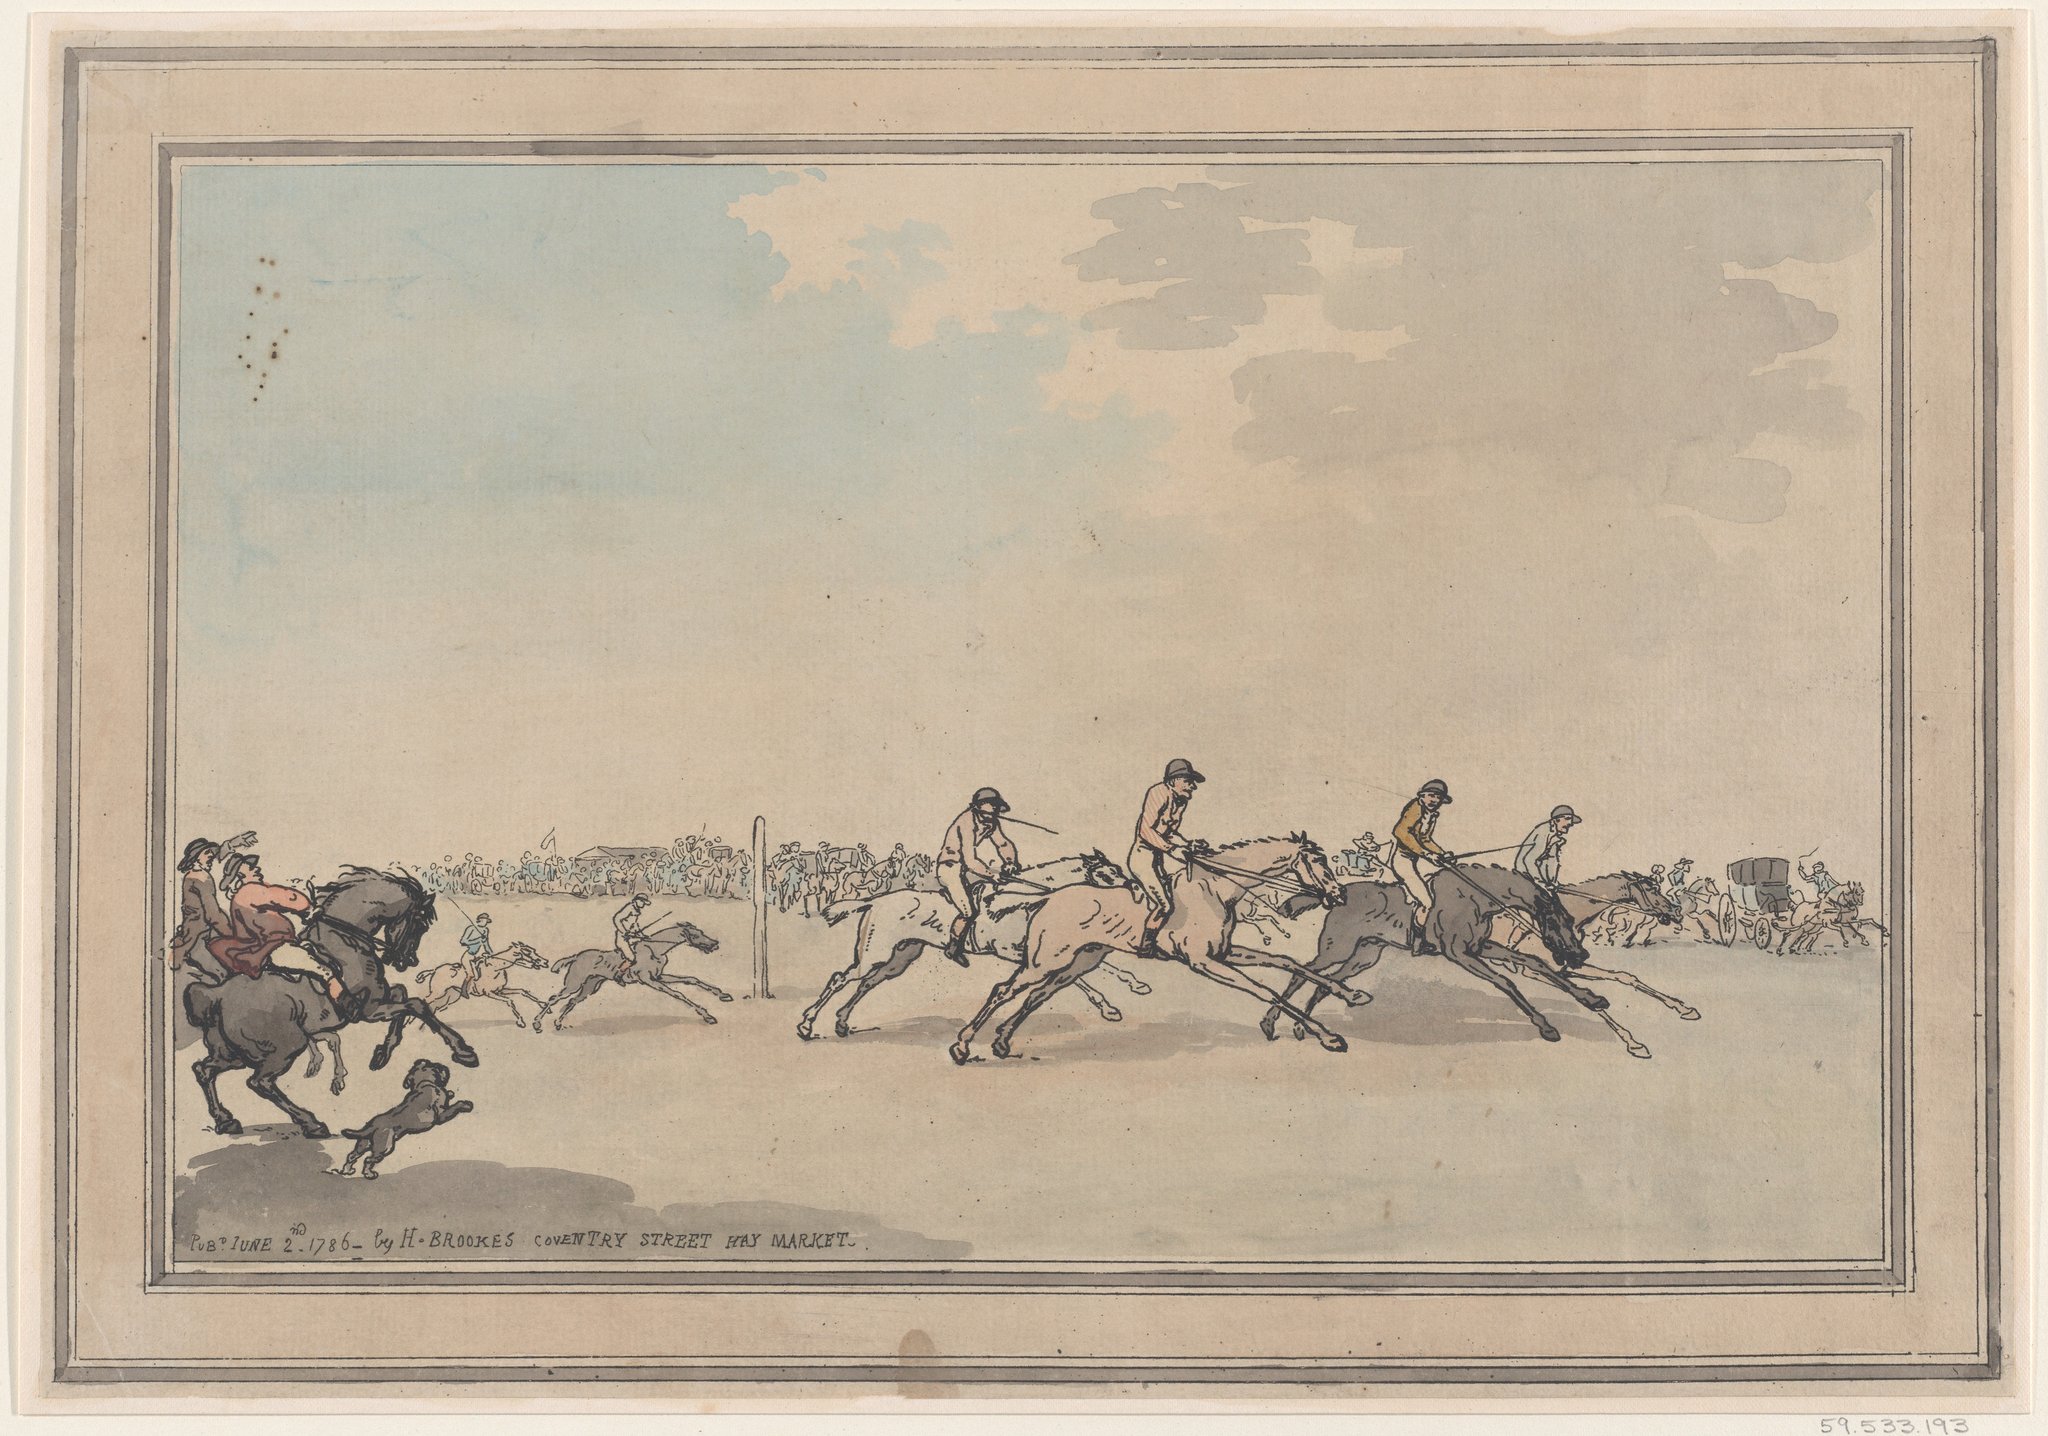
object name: print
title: The Start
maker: thomas rowlandson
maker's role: artist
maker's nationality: british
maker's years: 1757-1827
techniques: aquatint, etching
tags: horses,jockeys